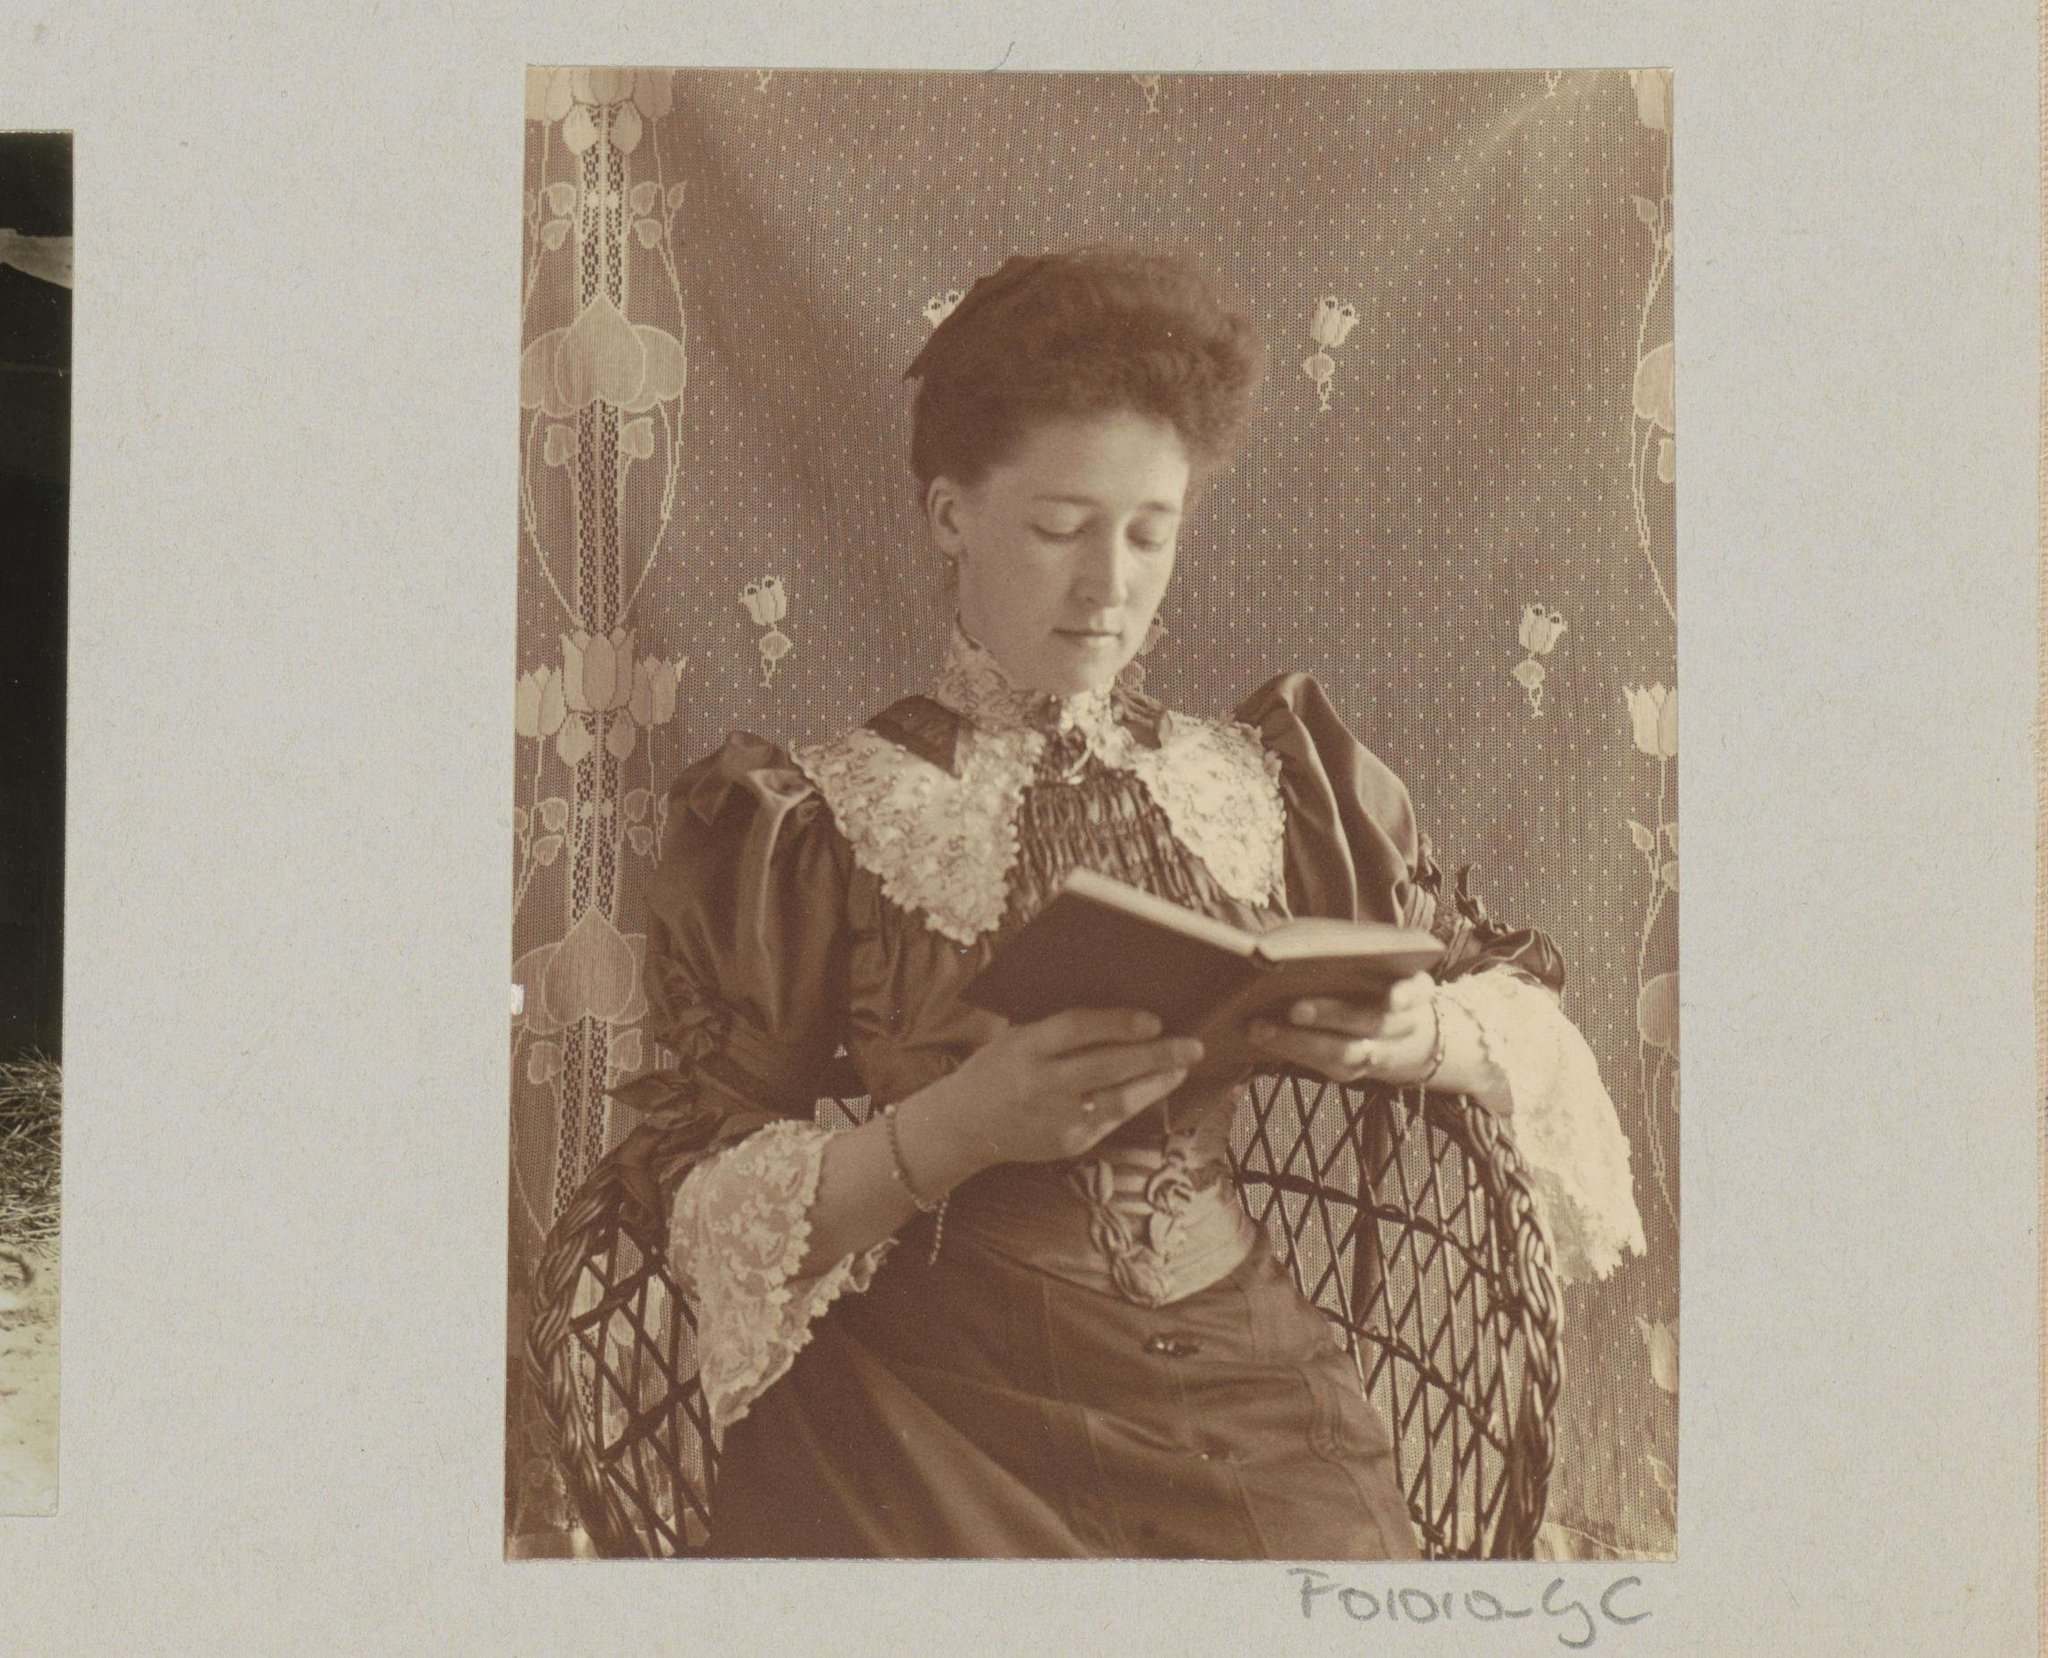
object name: photograph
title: Boeklezende vrouw, zittend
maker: Anonymous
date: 1900-1910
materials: photographic support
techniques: daylight paper print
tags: armchair, seat, reading, anonymous historical person portrayed - bb - woman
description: Onderdeel van Familiealbum met onder meer foto's van Wijnhandel Kraaij & Co. Bordeaux-Amsterdam.